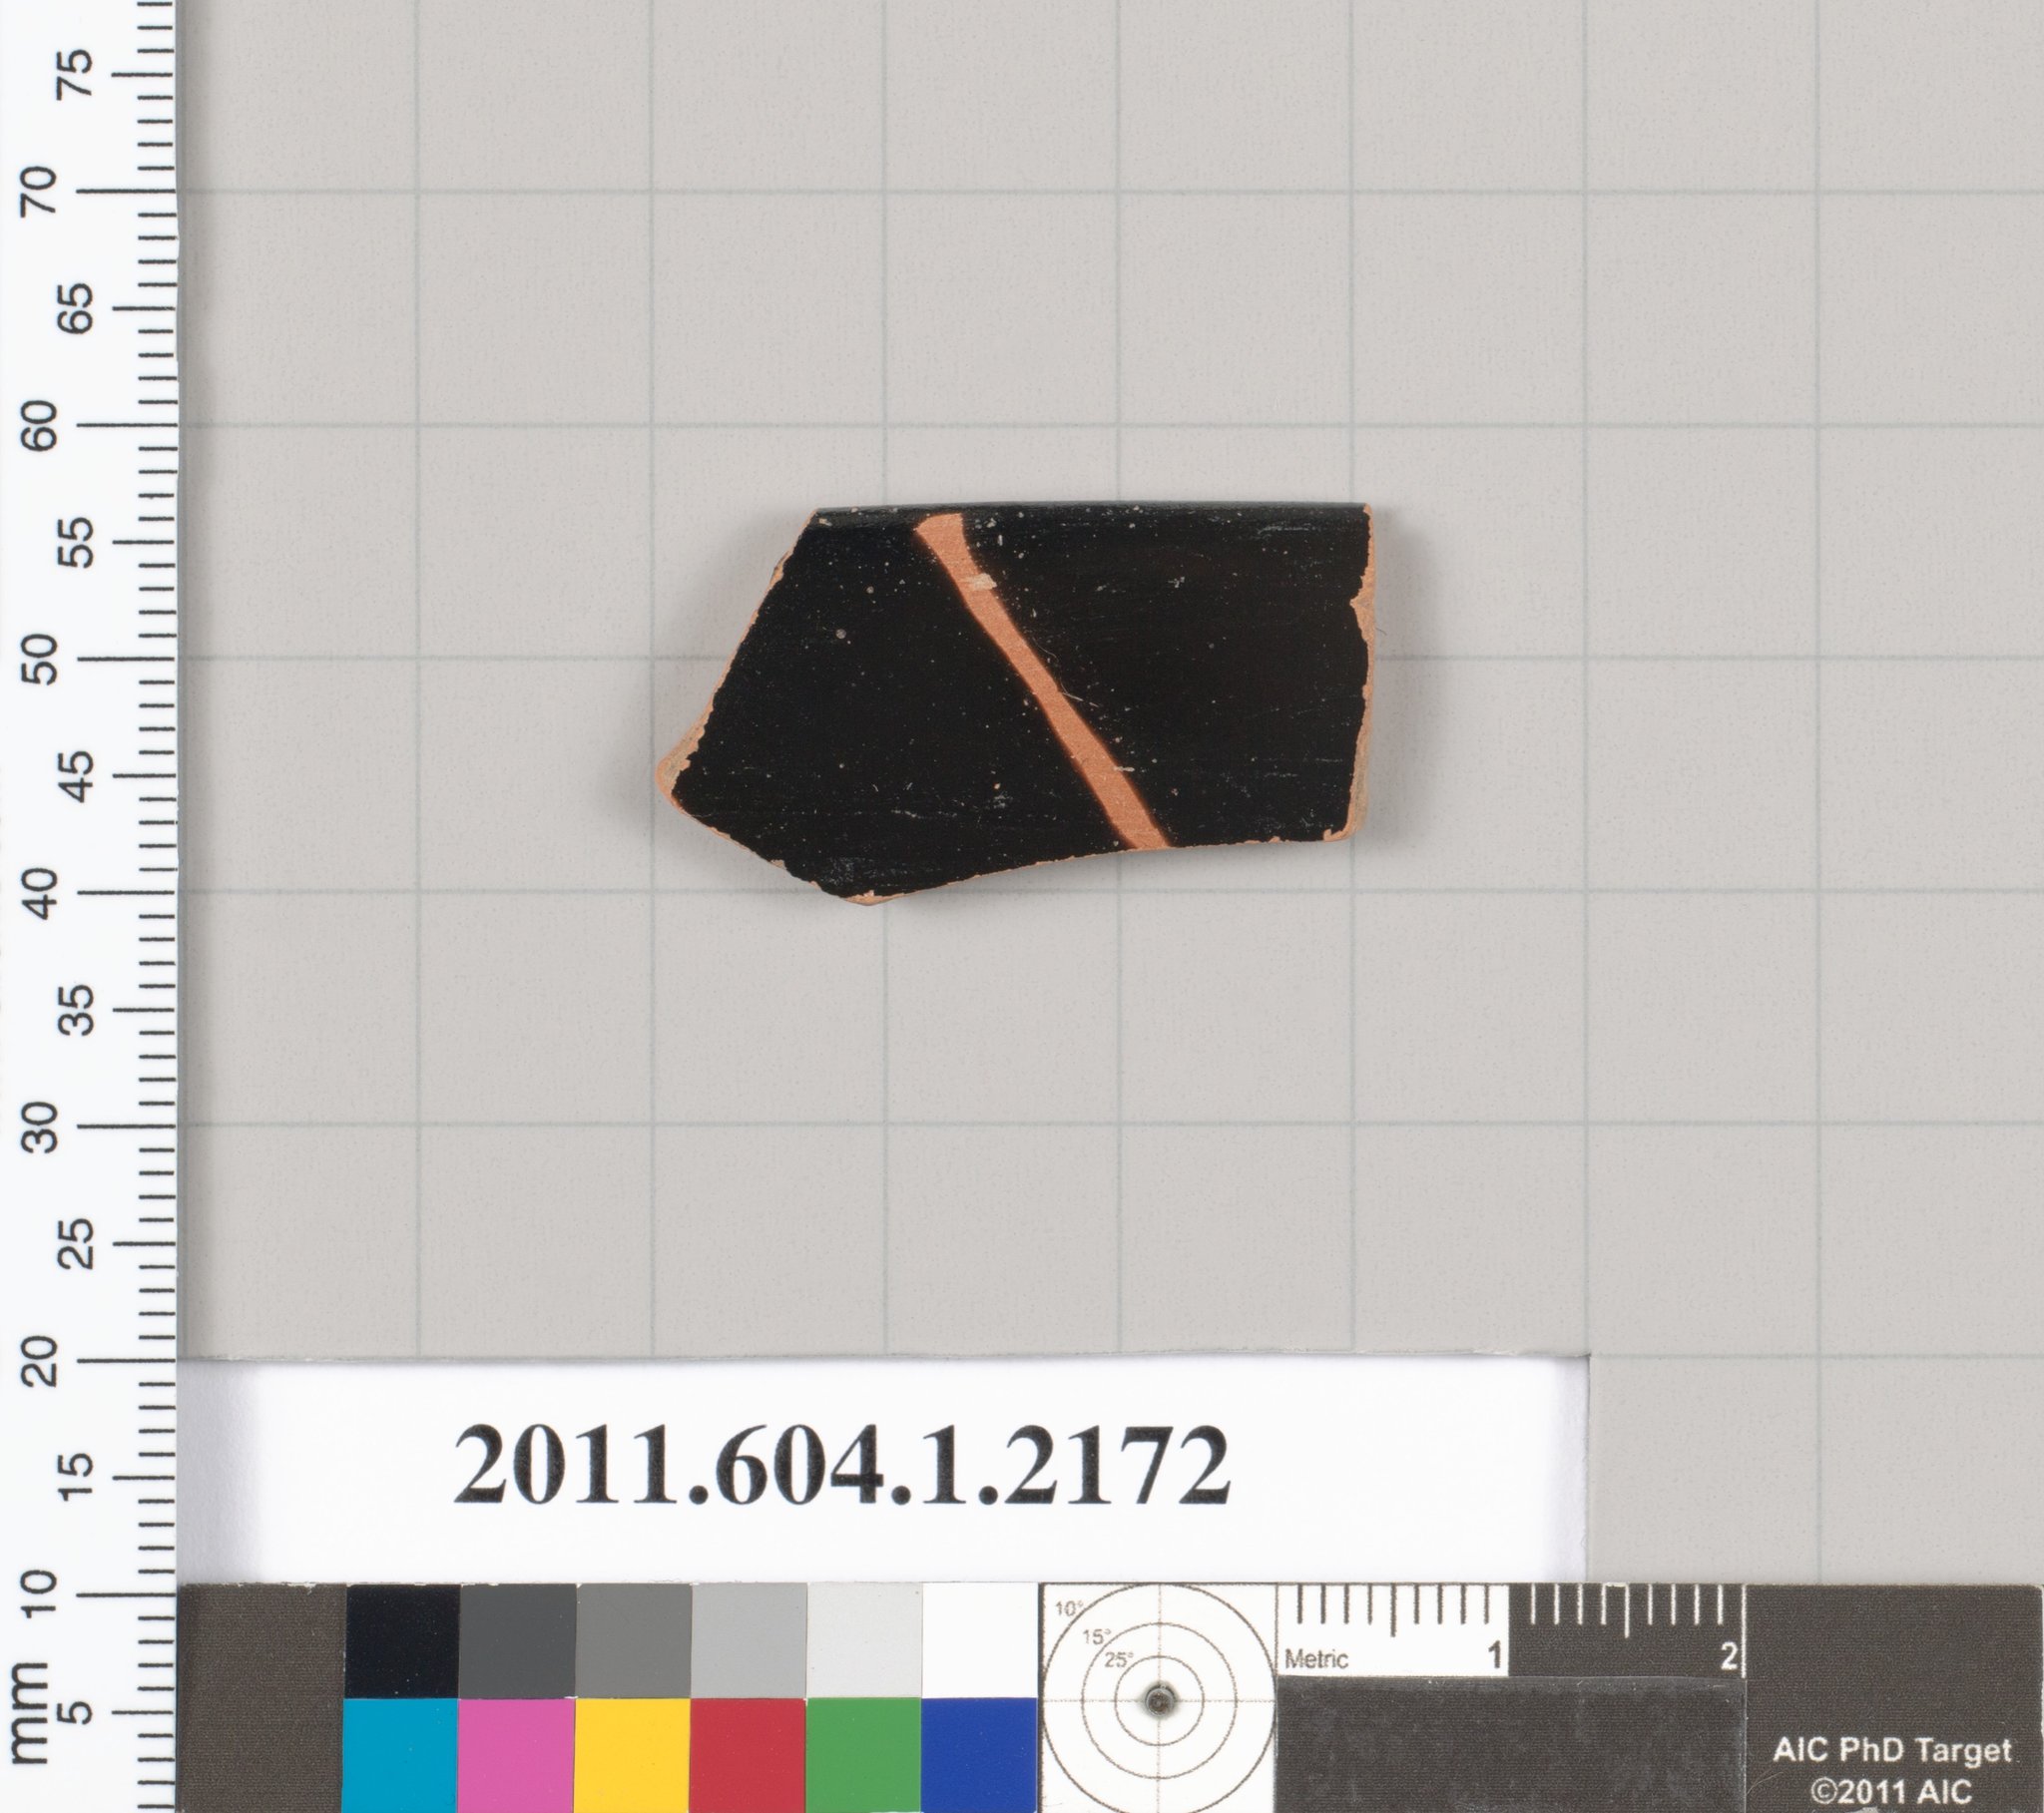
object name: kylix fragment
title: Terracotta rim fragment of a kylix (drinking cup)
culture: greek, attic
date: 500-401 BCE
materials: terracotta